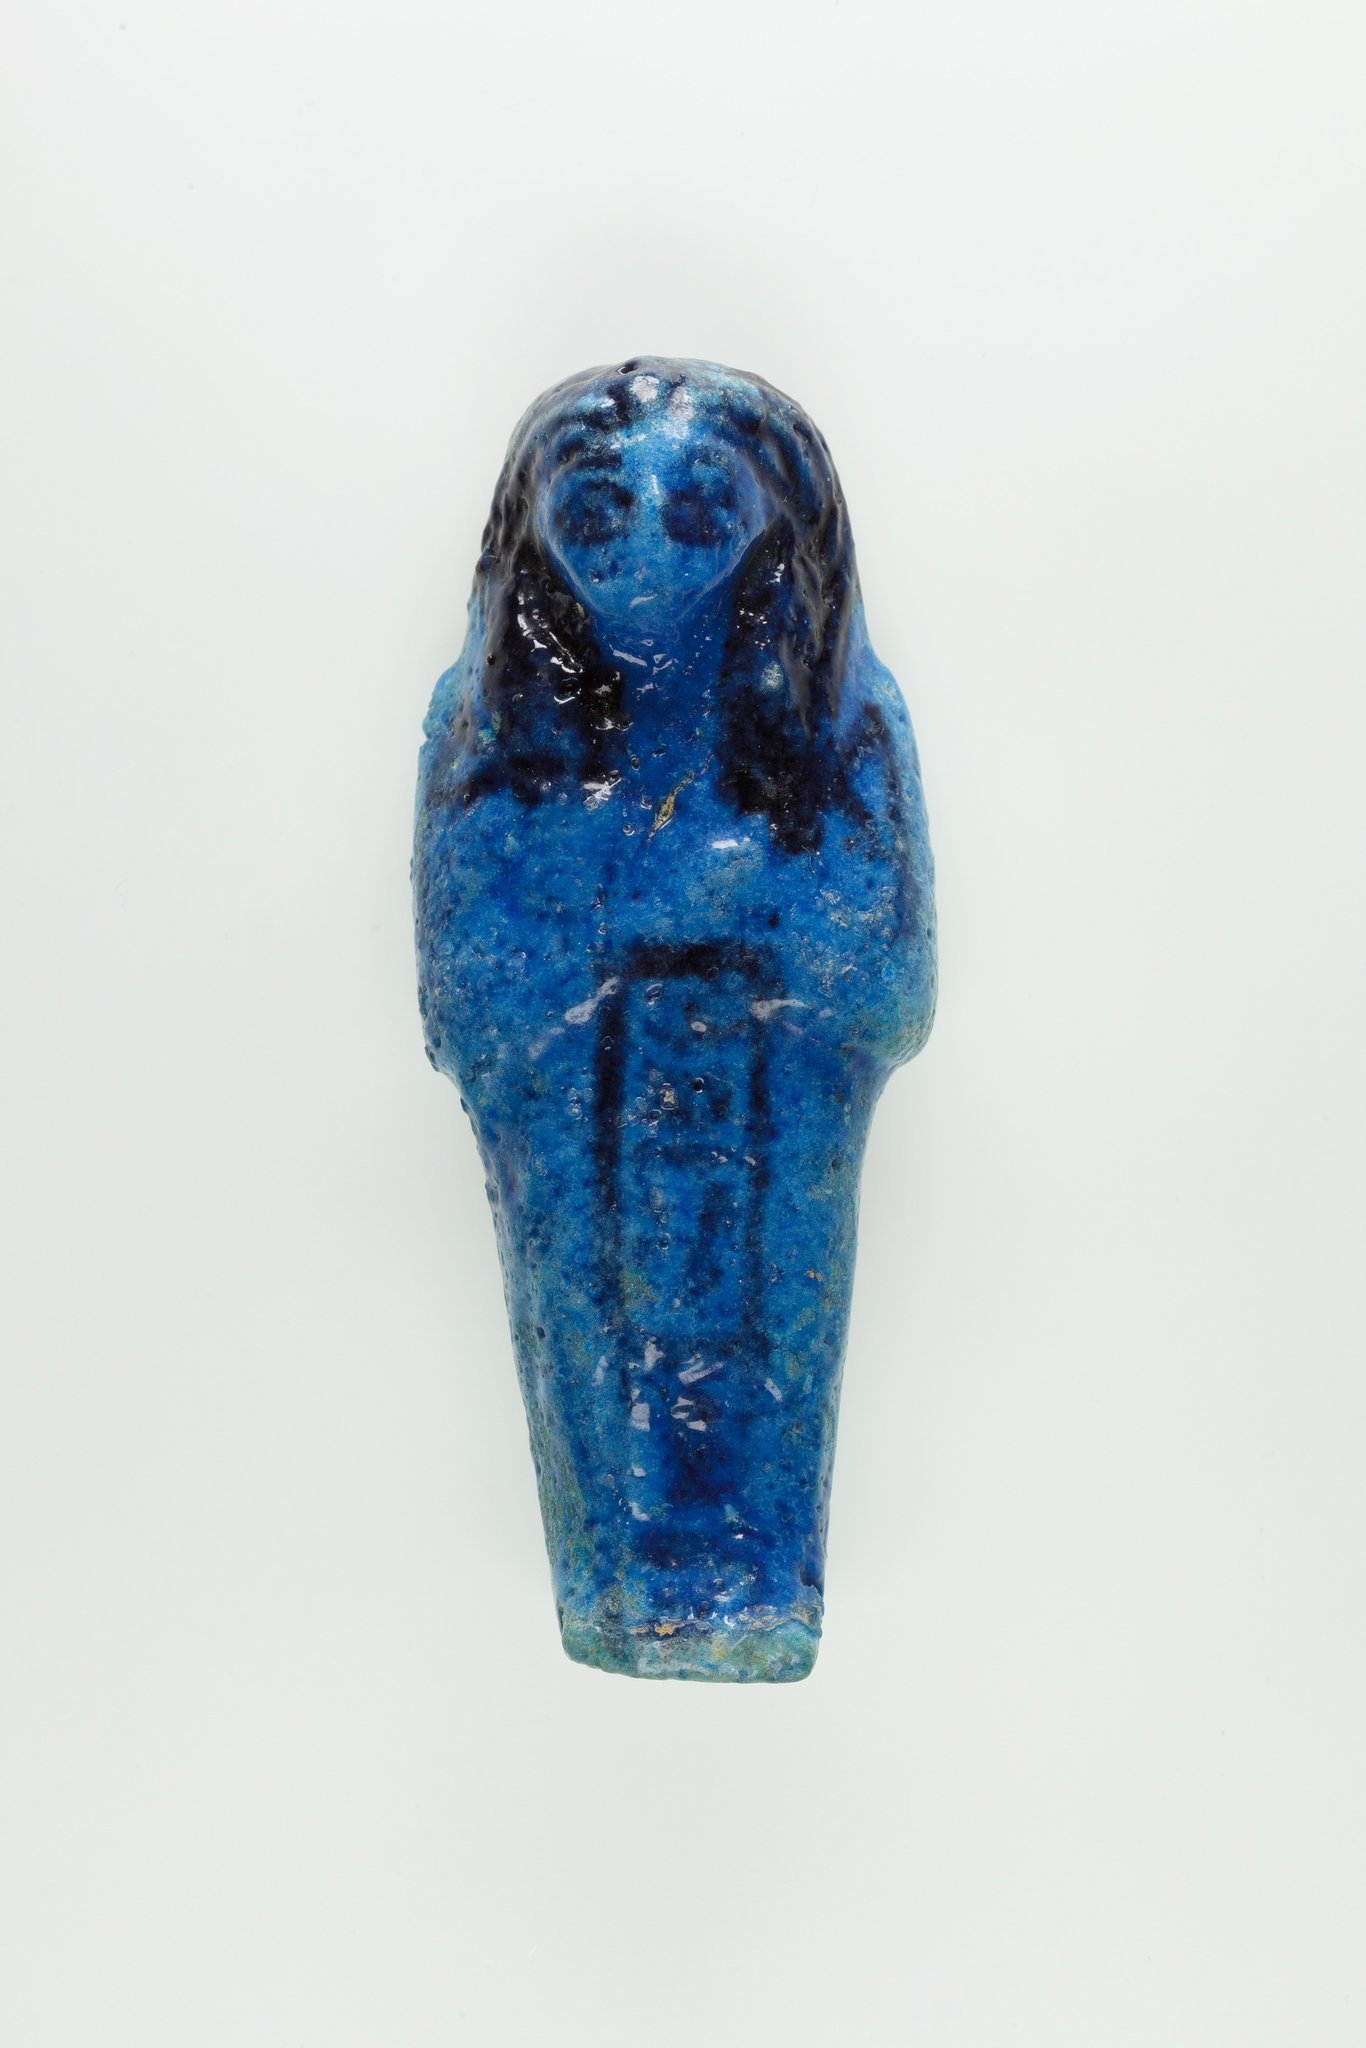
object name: shabti, worker, nauny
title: Worker Shabti of Nauny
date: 1050 BCE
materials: faience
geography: egypt